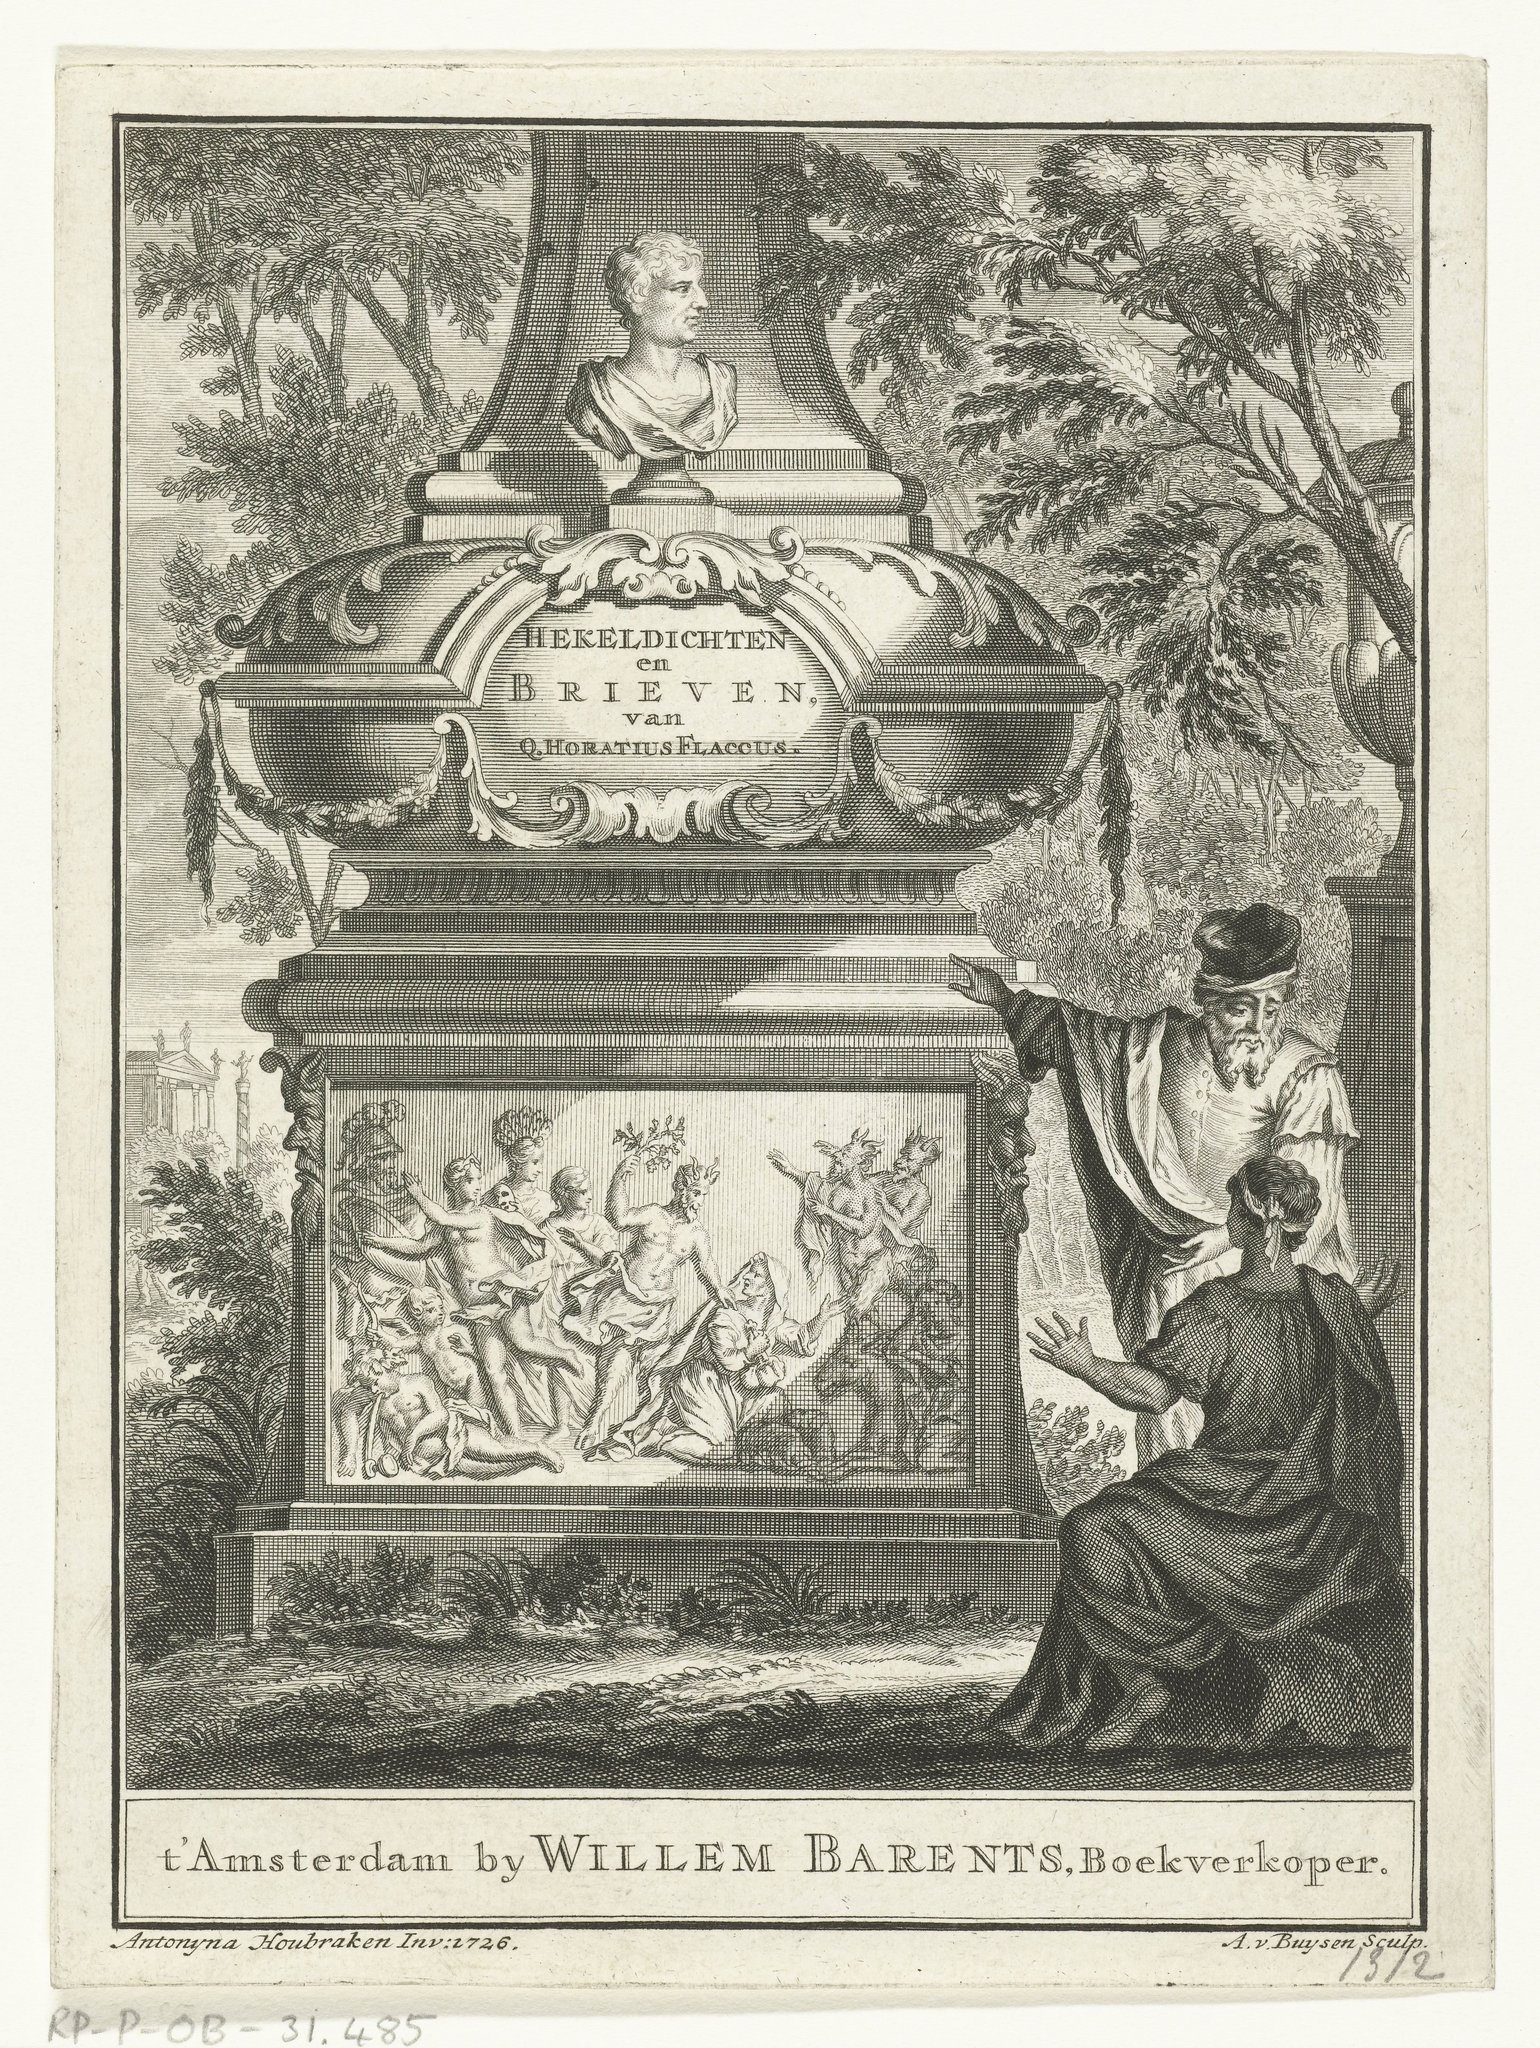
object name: titelblad, titelpagina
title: Grafmonument met afbeelding van een bacchanaal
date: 1726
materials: paper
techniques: etching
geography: amsterdam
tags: venosa, rome, horatius, thiasos, i.e. bacchus' revel-rout, bacchanal without bacchus, historical persons (portraits and scenes from the life) (+ profile portrait), grave-building, monumental tomb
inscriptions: date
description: Twee mannen kijken naar een grafmonument waarop een afbeelding van een feest ter ere van de God Bacchus te zien is. Boven de sokkel rust een sarcofaag met een portretbuste van de Romeinse dichter Quintus Horatius Flaccus.